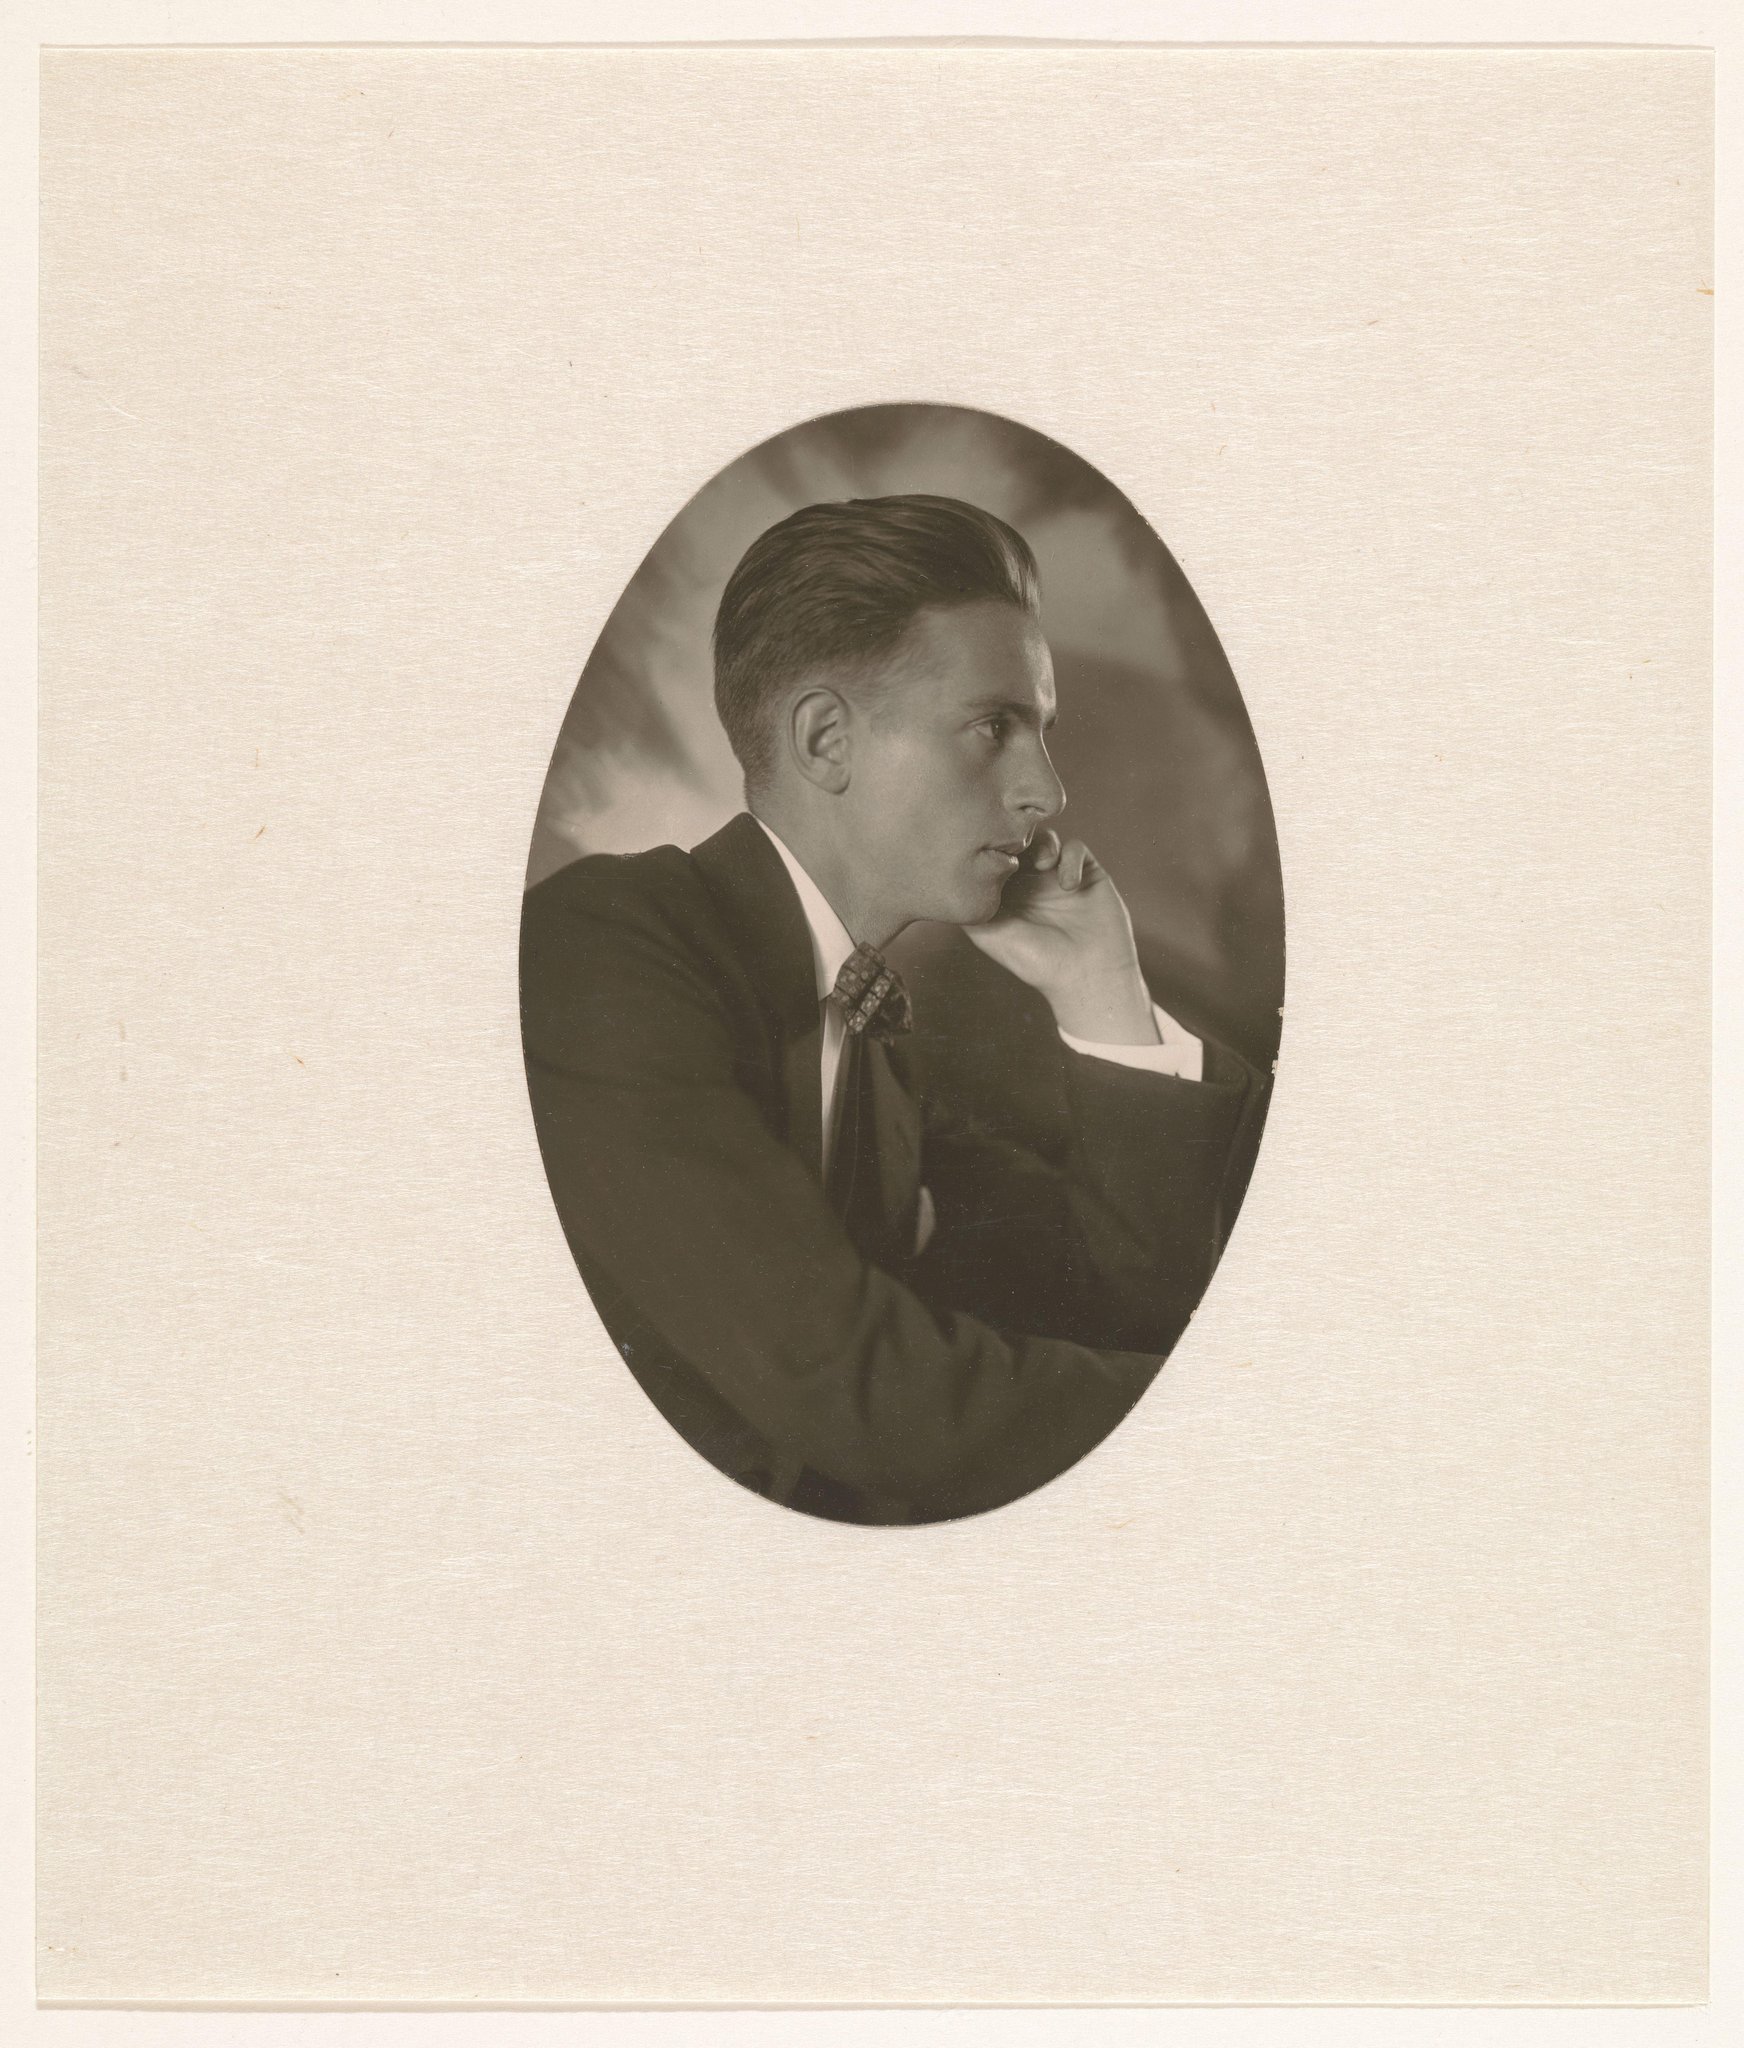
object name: photograph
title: Ovaal portret van Hans Kaestner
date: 1920-1940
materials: paper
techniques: gelatin silver print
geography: the hague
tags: historical persons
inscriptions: name: ‘Hans Kaestner’, signature: ‘Foto atelier Frans Hals’